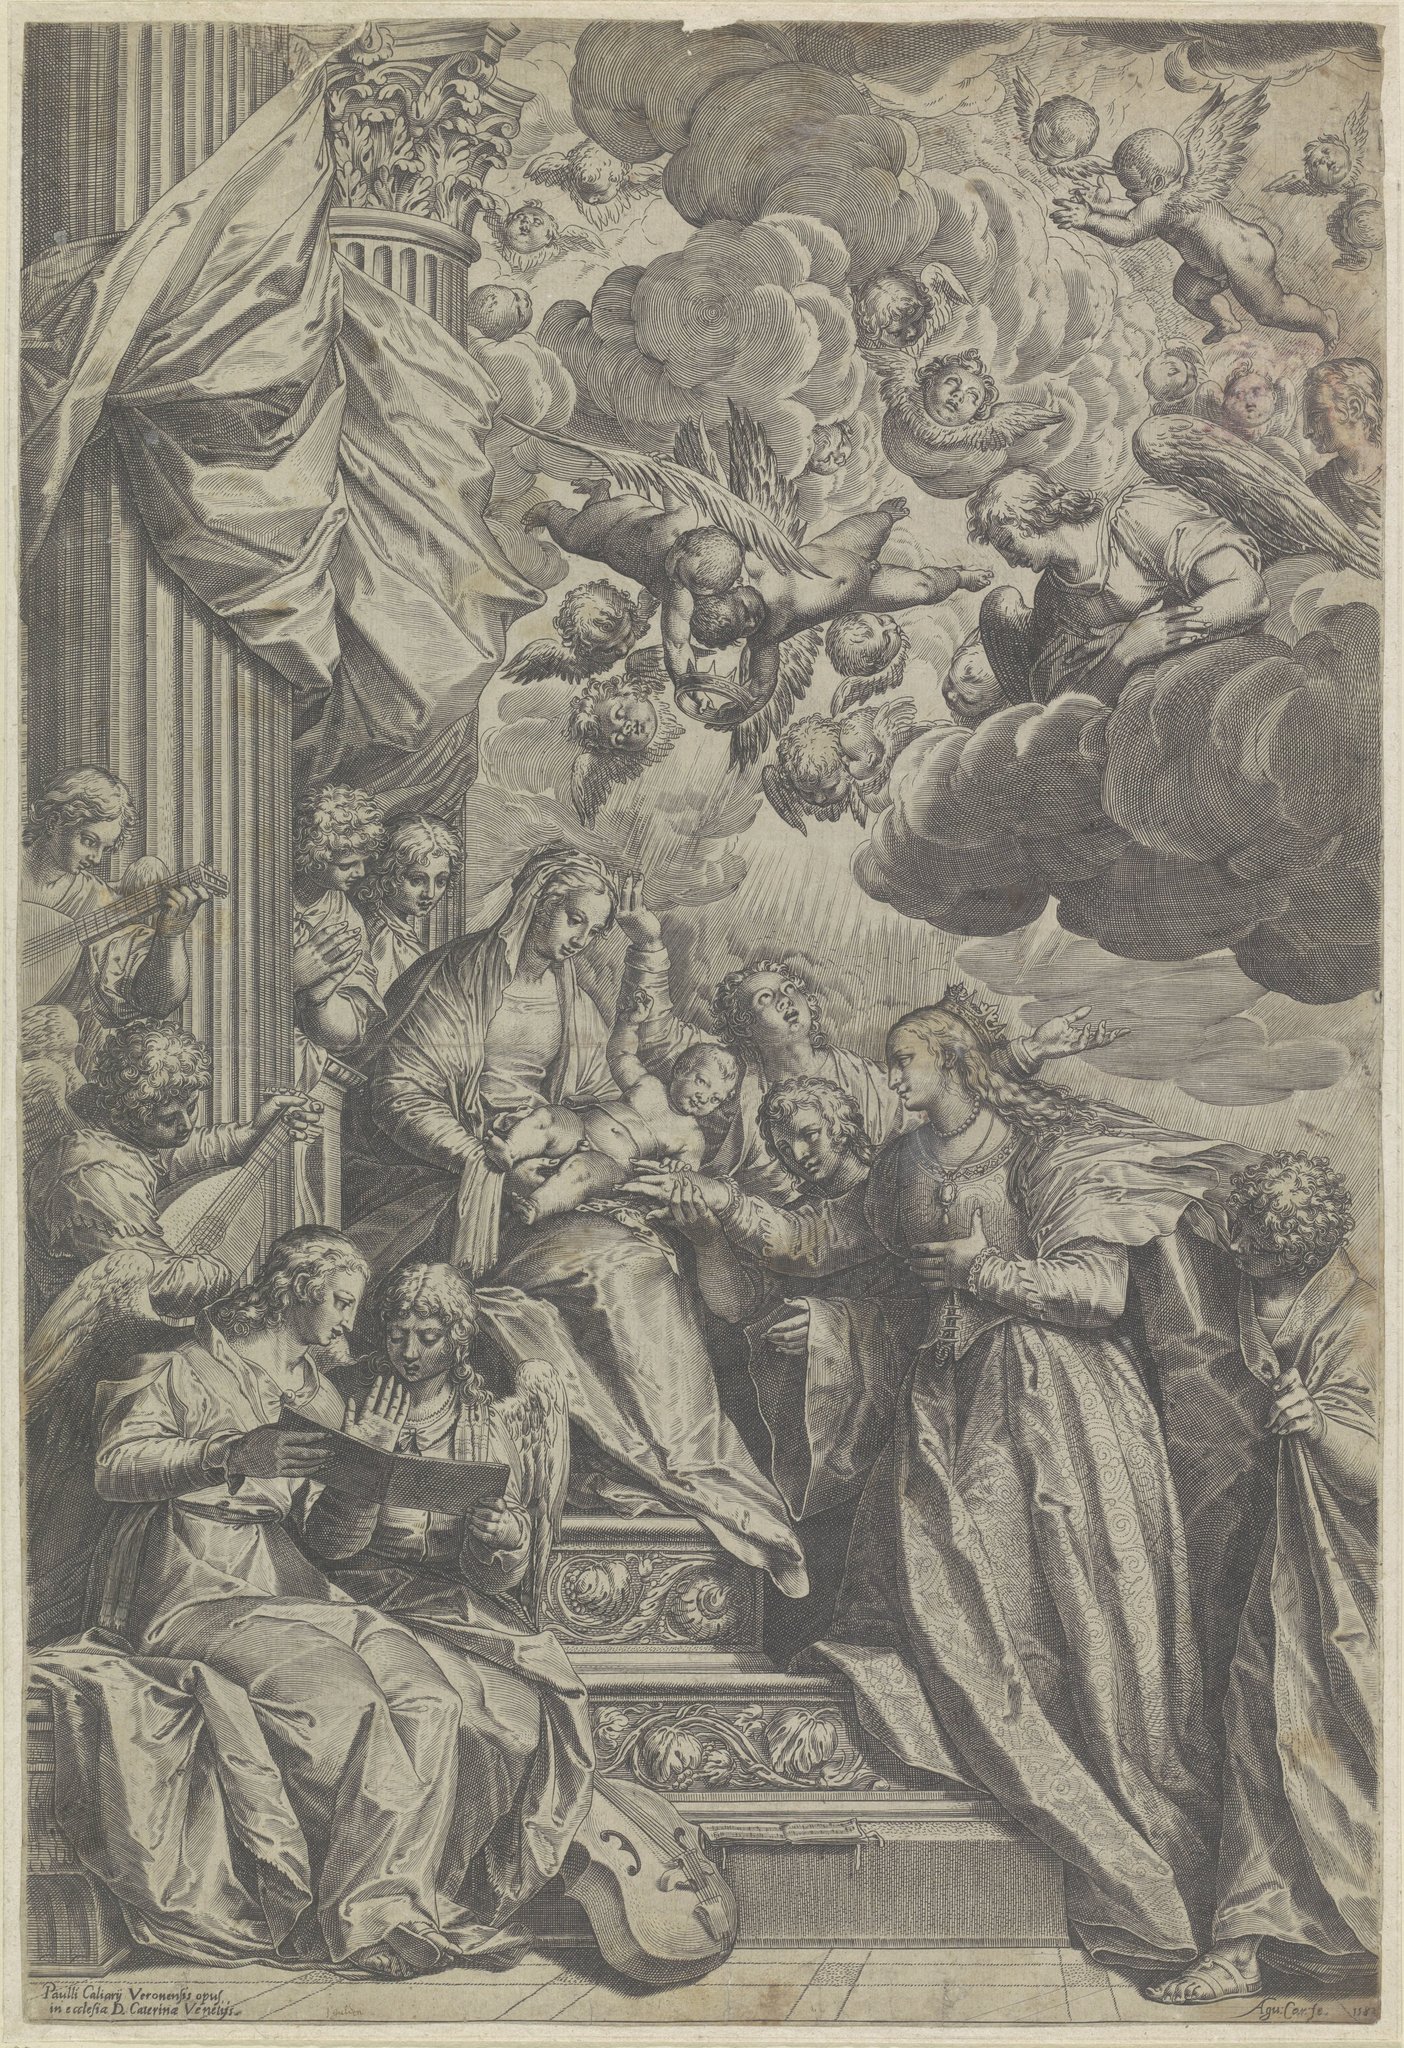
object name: print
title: Mystieke huwelijk van de heilige Catharina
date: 1582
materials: paper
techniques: engraving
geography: venice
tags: the mystic marriage of st. catherine of alexandria with the infant christ: the christ-child puts a ring on her finger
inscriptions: collector's mark: Lugt 240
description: Maria troont met het Christuskind op schoot. Christus staat op het punt een ring aan de vinger van de heilige Catharina van Alexandrië te schuiven. Op de voorgrond links een groep musicerende engelen. Boven rechts een groep zwevende engelen en putti.